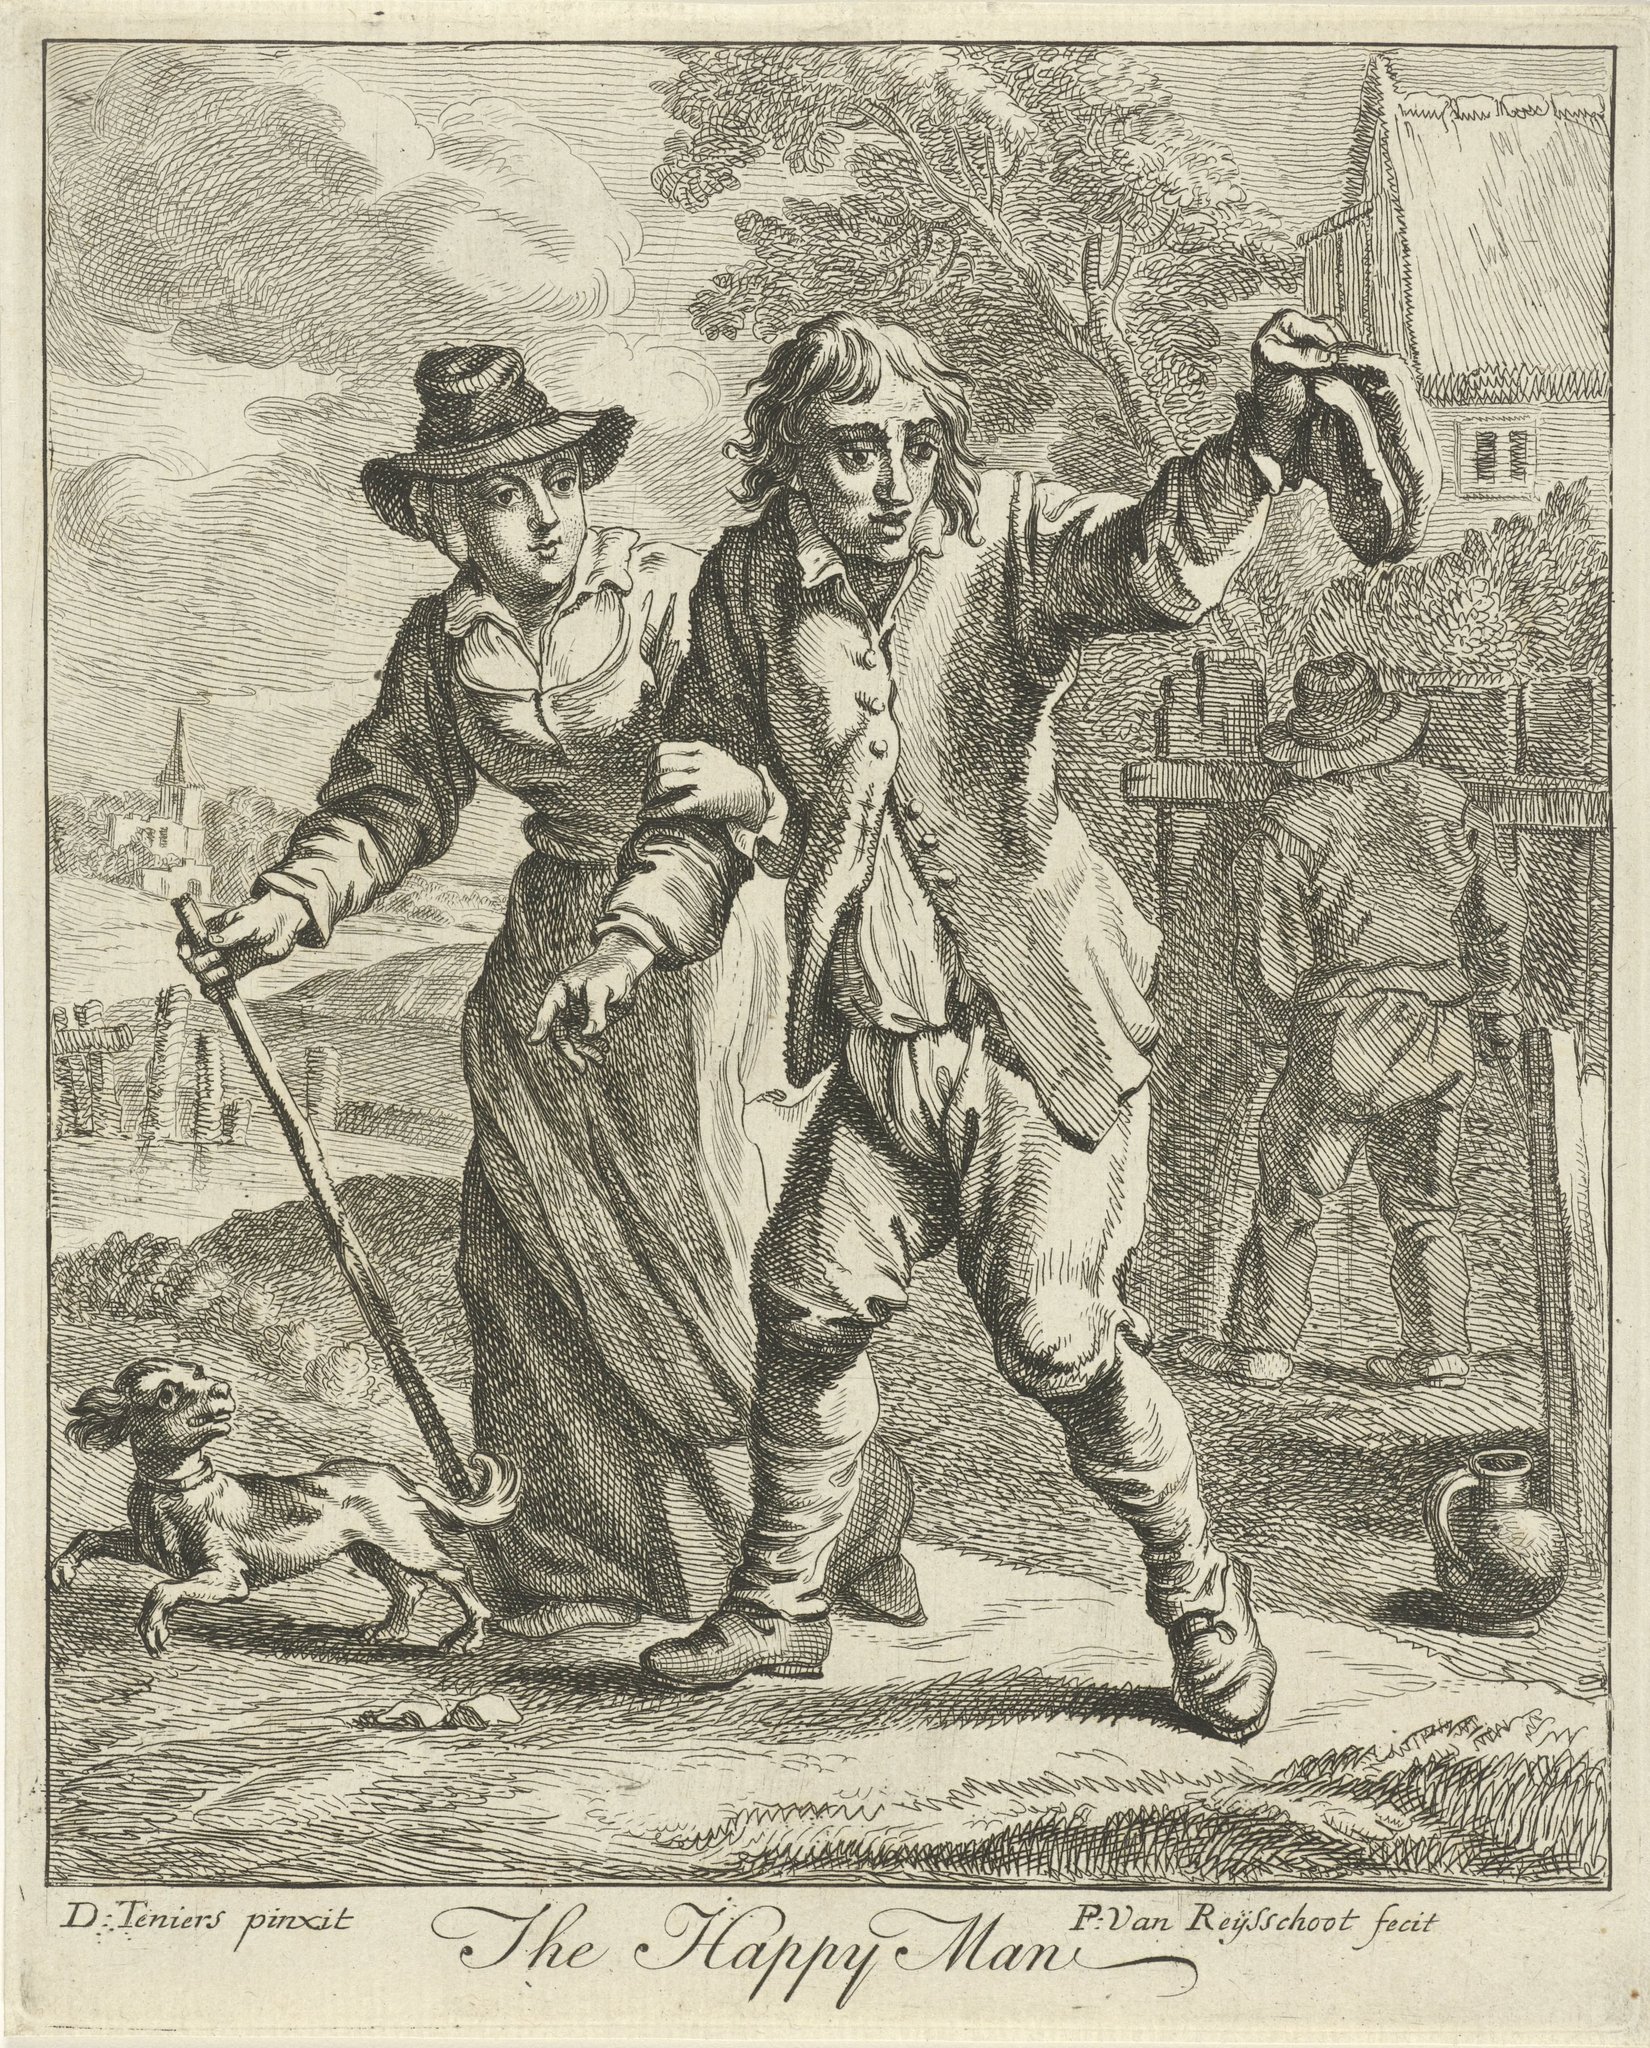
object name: print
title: The happy man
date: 1712-1772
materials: paper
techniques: etching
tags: arm in arm (lovers)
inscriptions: collector's mark: Lugt 2228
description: Bij een dorp wandelt een paar. De man wuift met zijn muts en voor het paar huppelt een hondje. Op de achtergrond staat een man bij een hek.